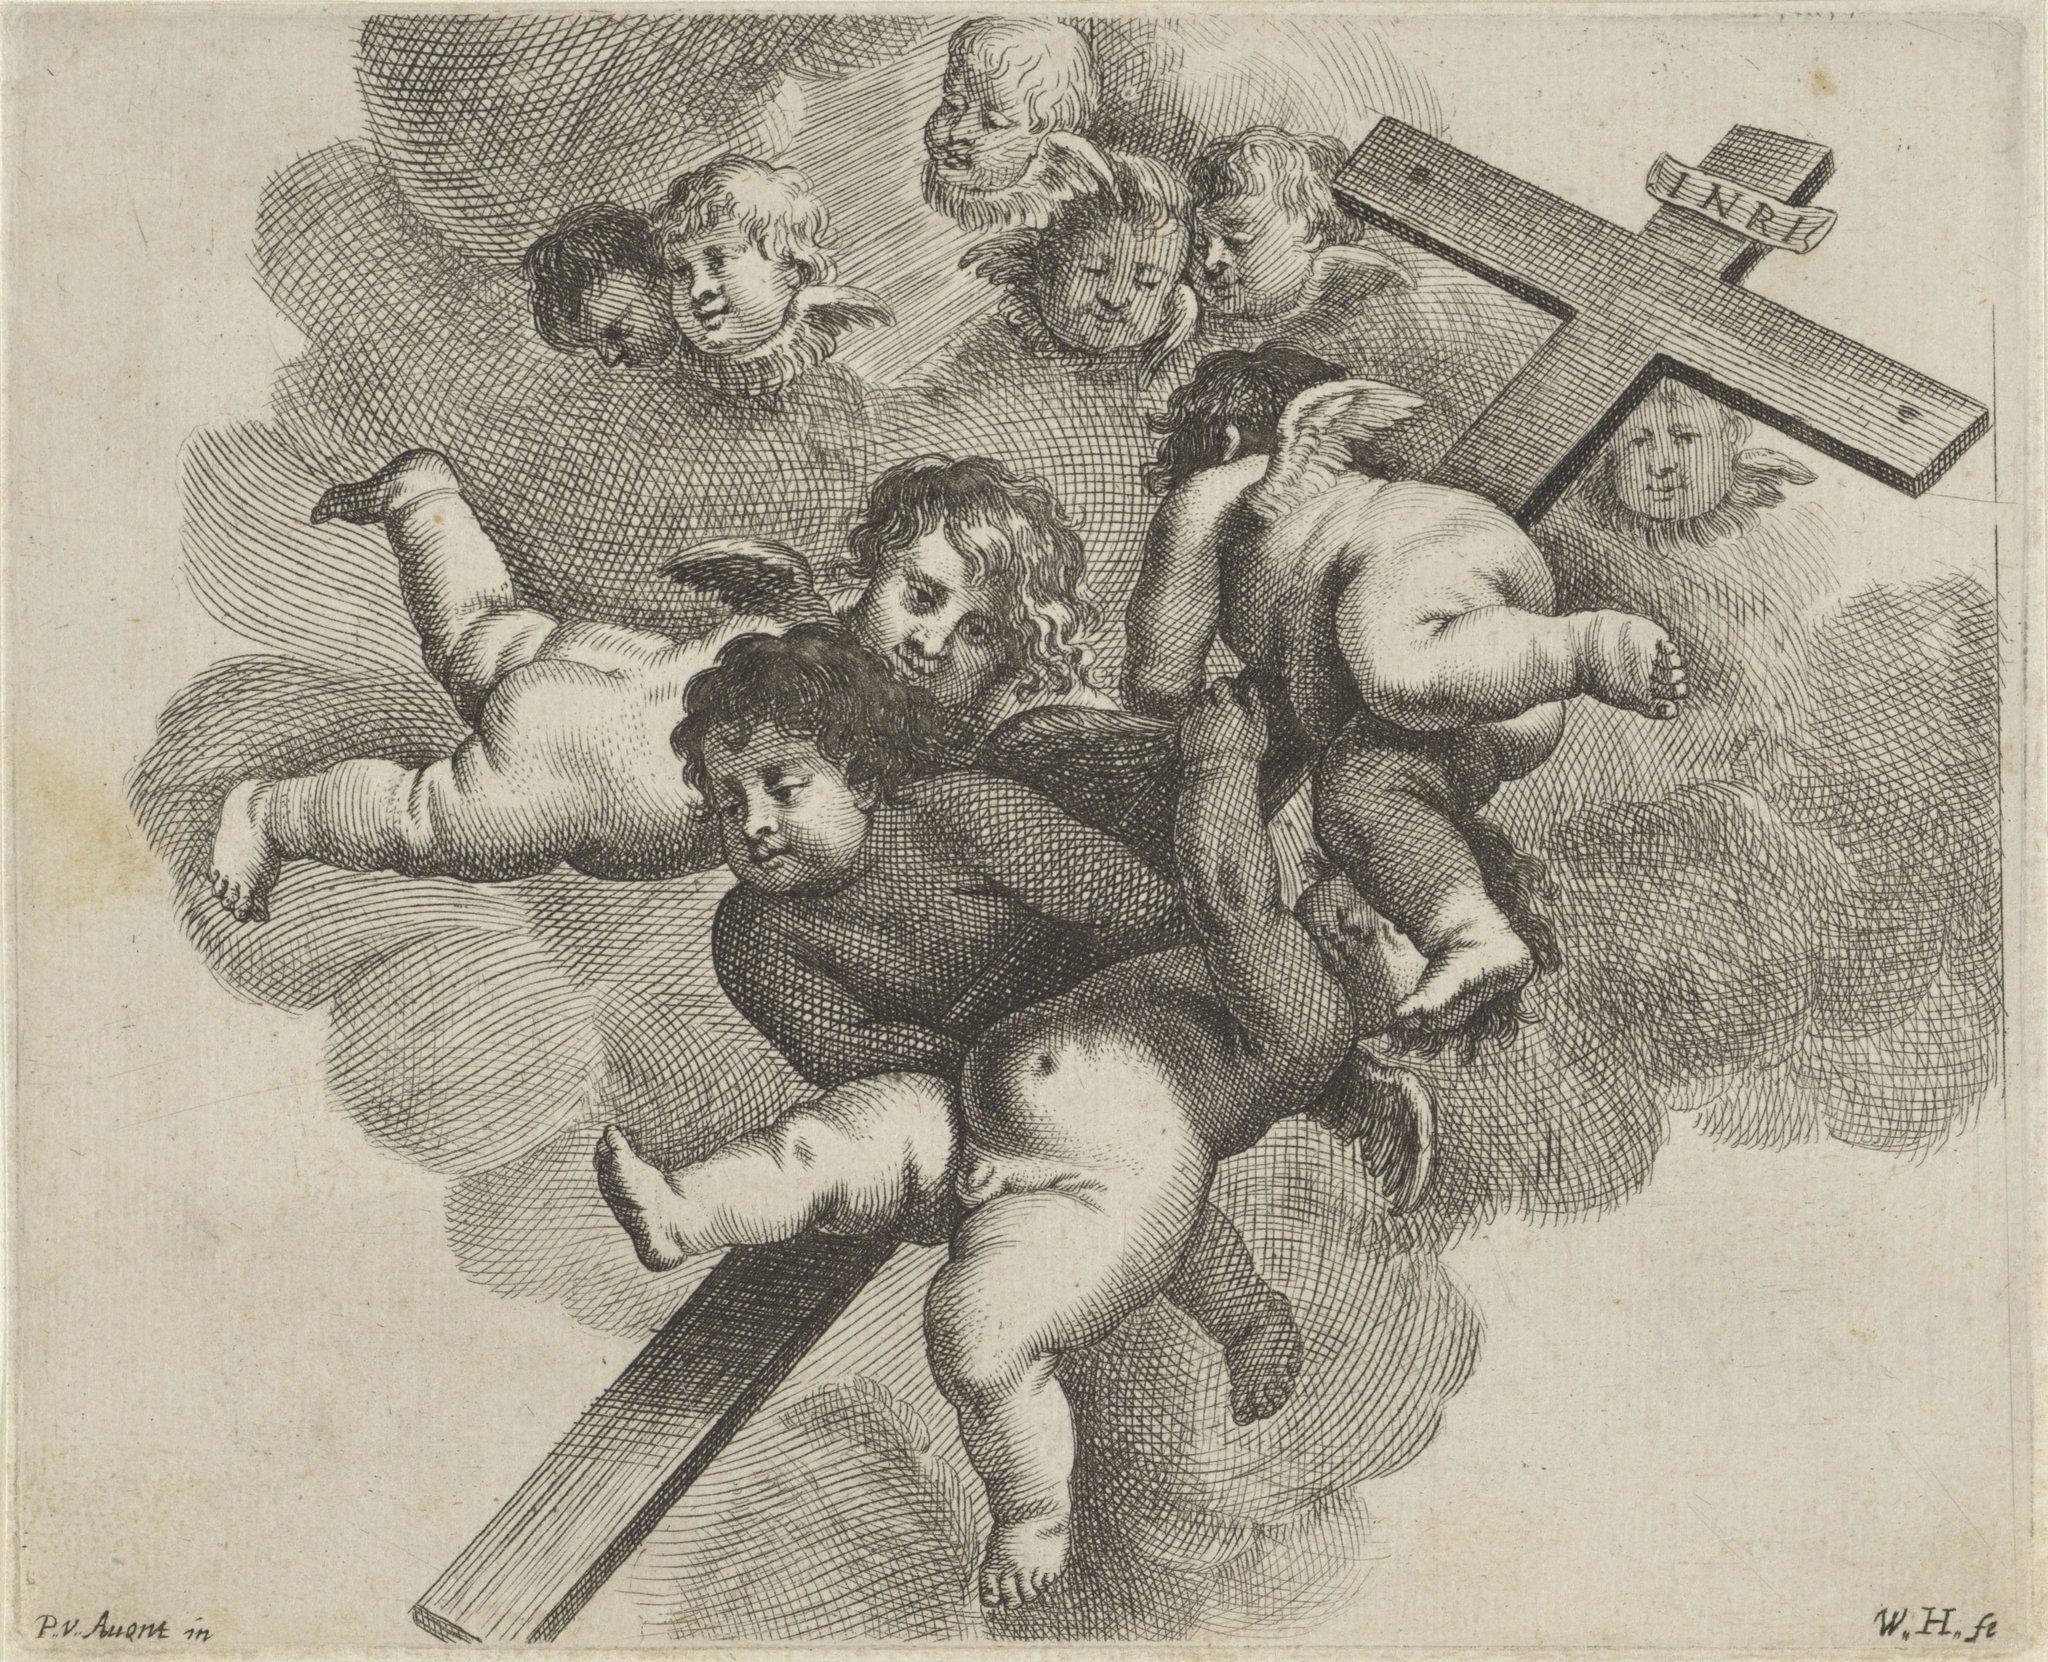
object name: print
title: Cherubijnen dragen gezamenlijk een kruis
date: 1625-1727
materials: paper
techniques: etching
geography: antwerp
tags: the cross ~ symbols of christ, cupids: 'amores', 'amoretti', 'putti'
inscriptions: collector's mark: Lugt 2228